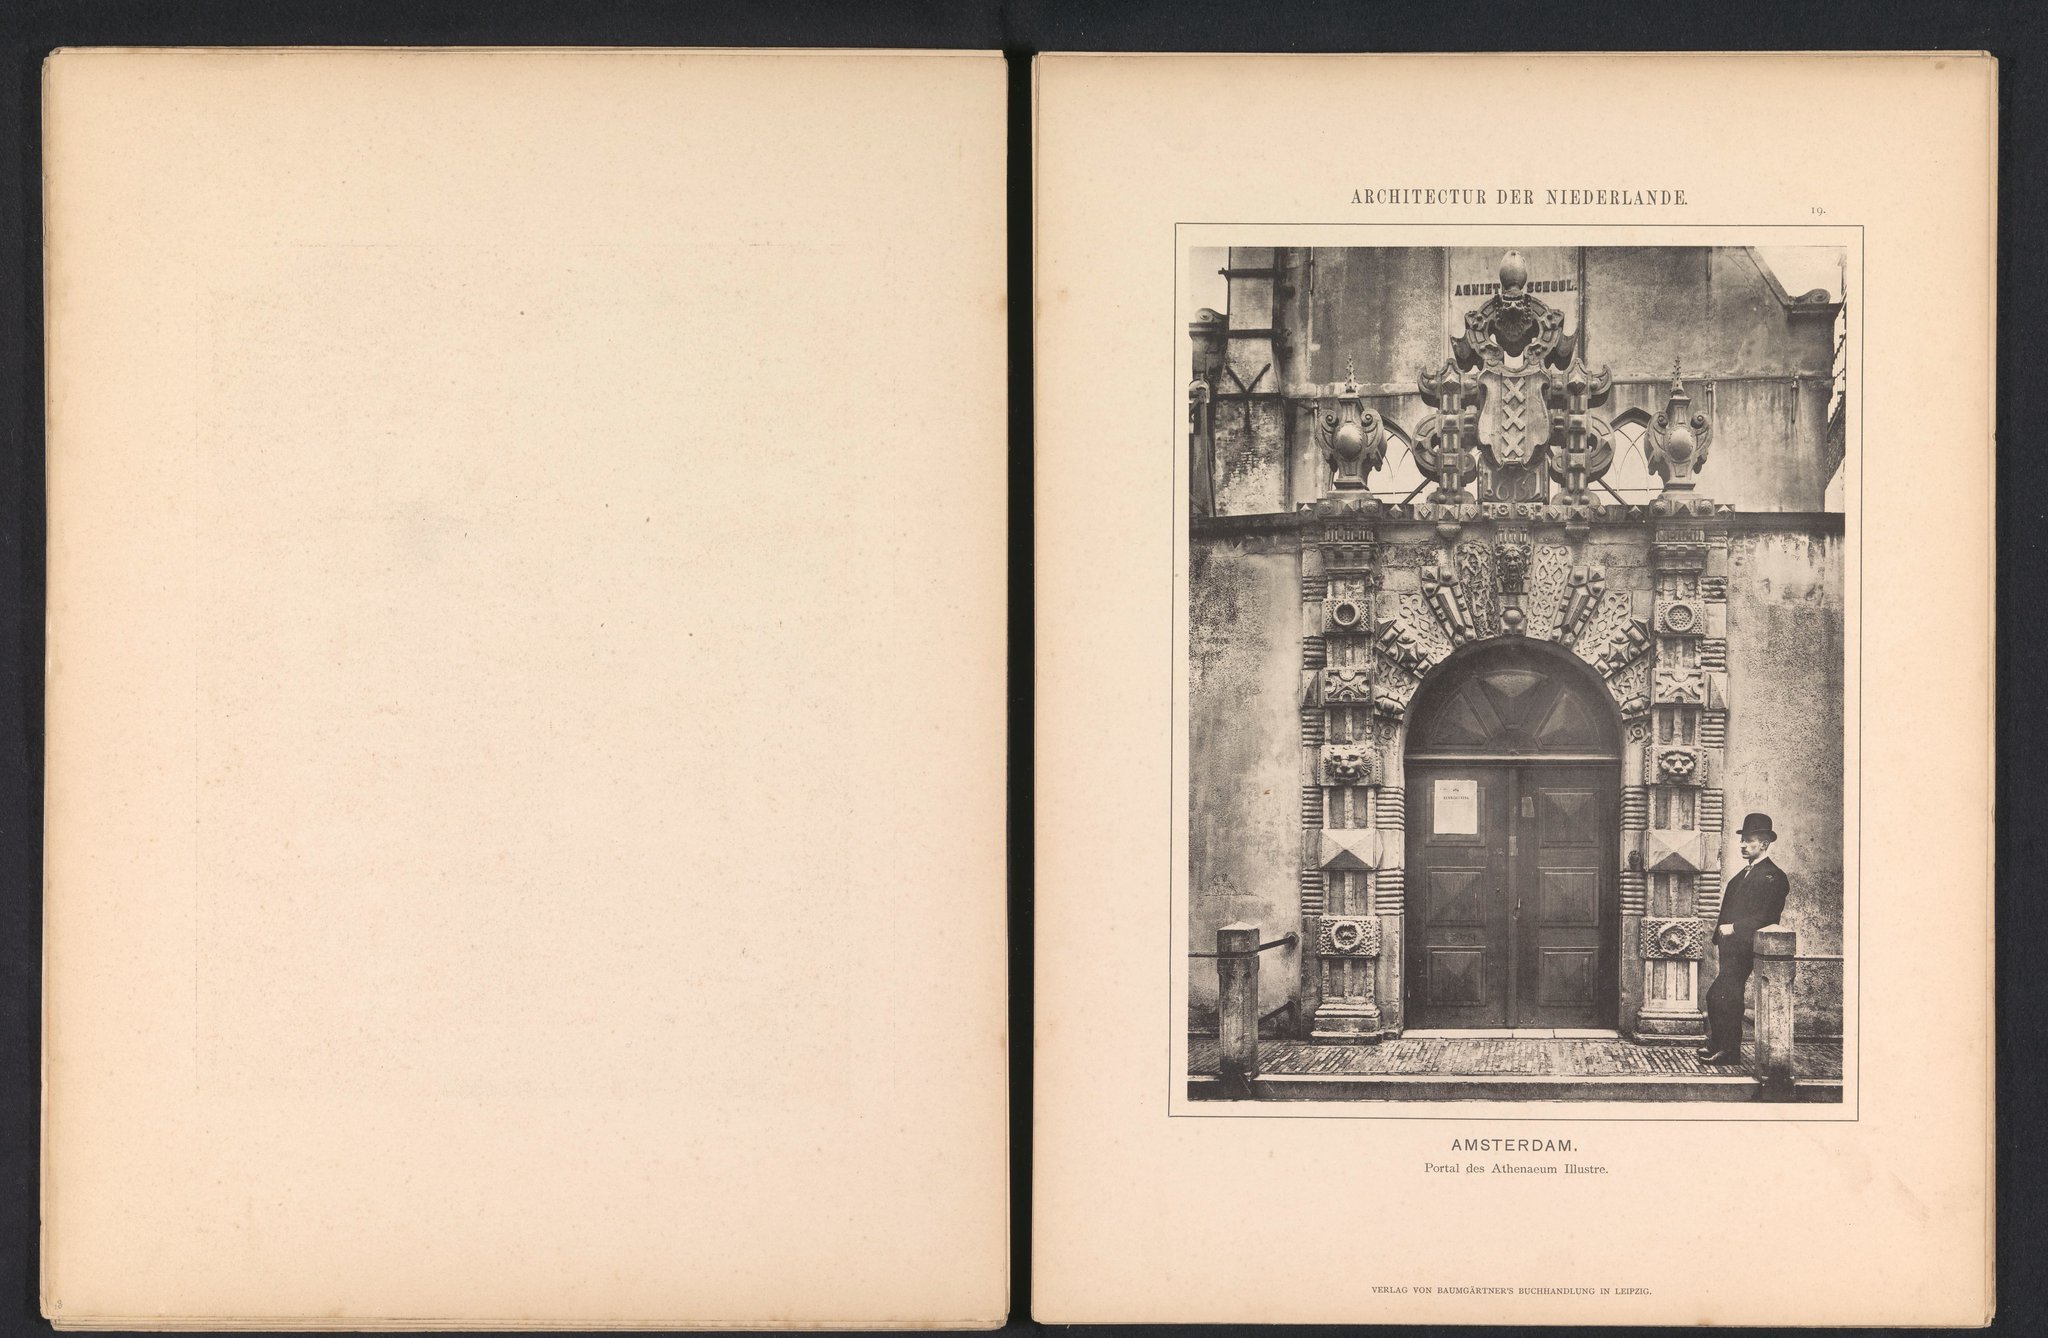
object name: page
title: Amsterdam. Portal des Athenaeum Illustre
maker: Anonymous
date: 1884-1894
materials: paper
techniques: photograph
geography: amsterdam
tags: secondary education, gate, entrance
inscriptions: number: ‘19.’